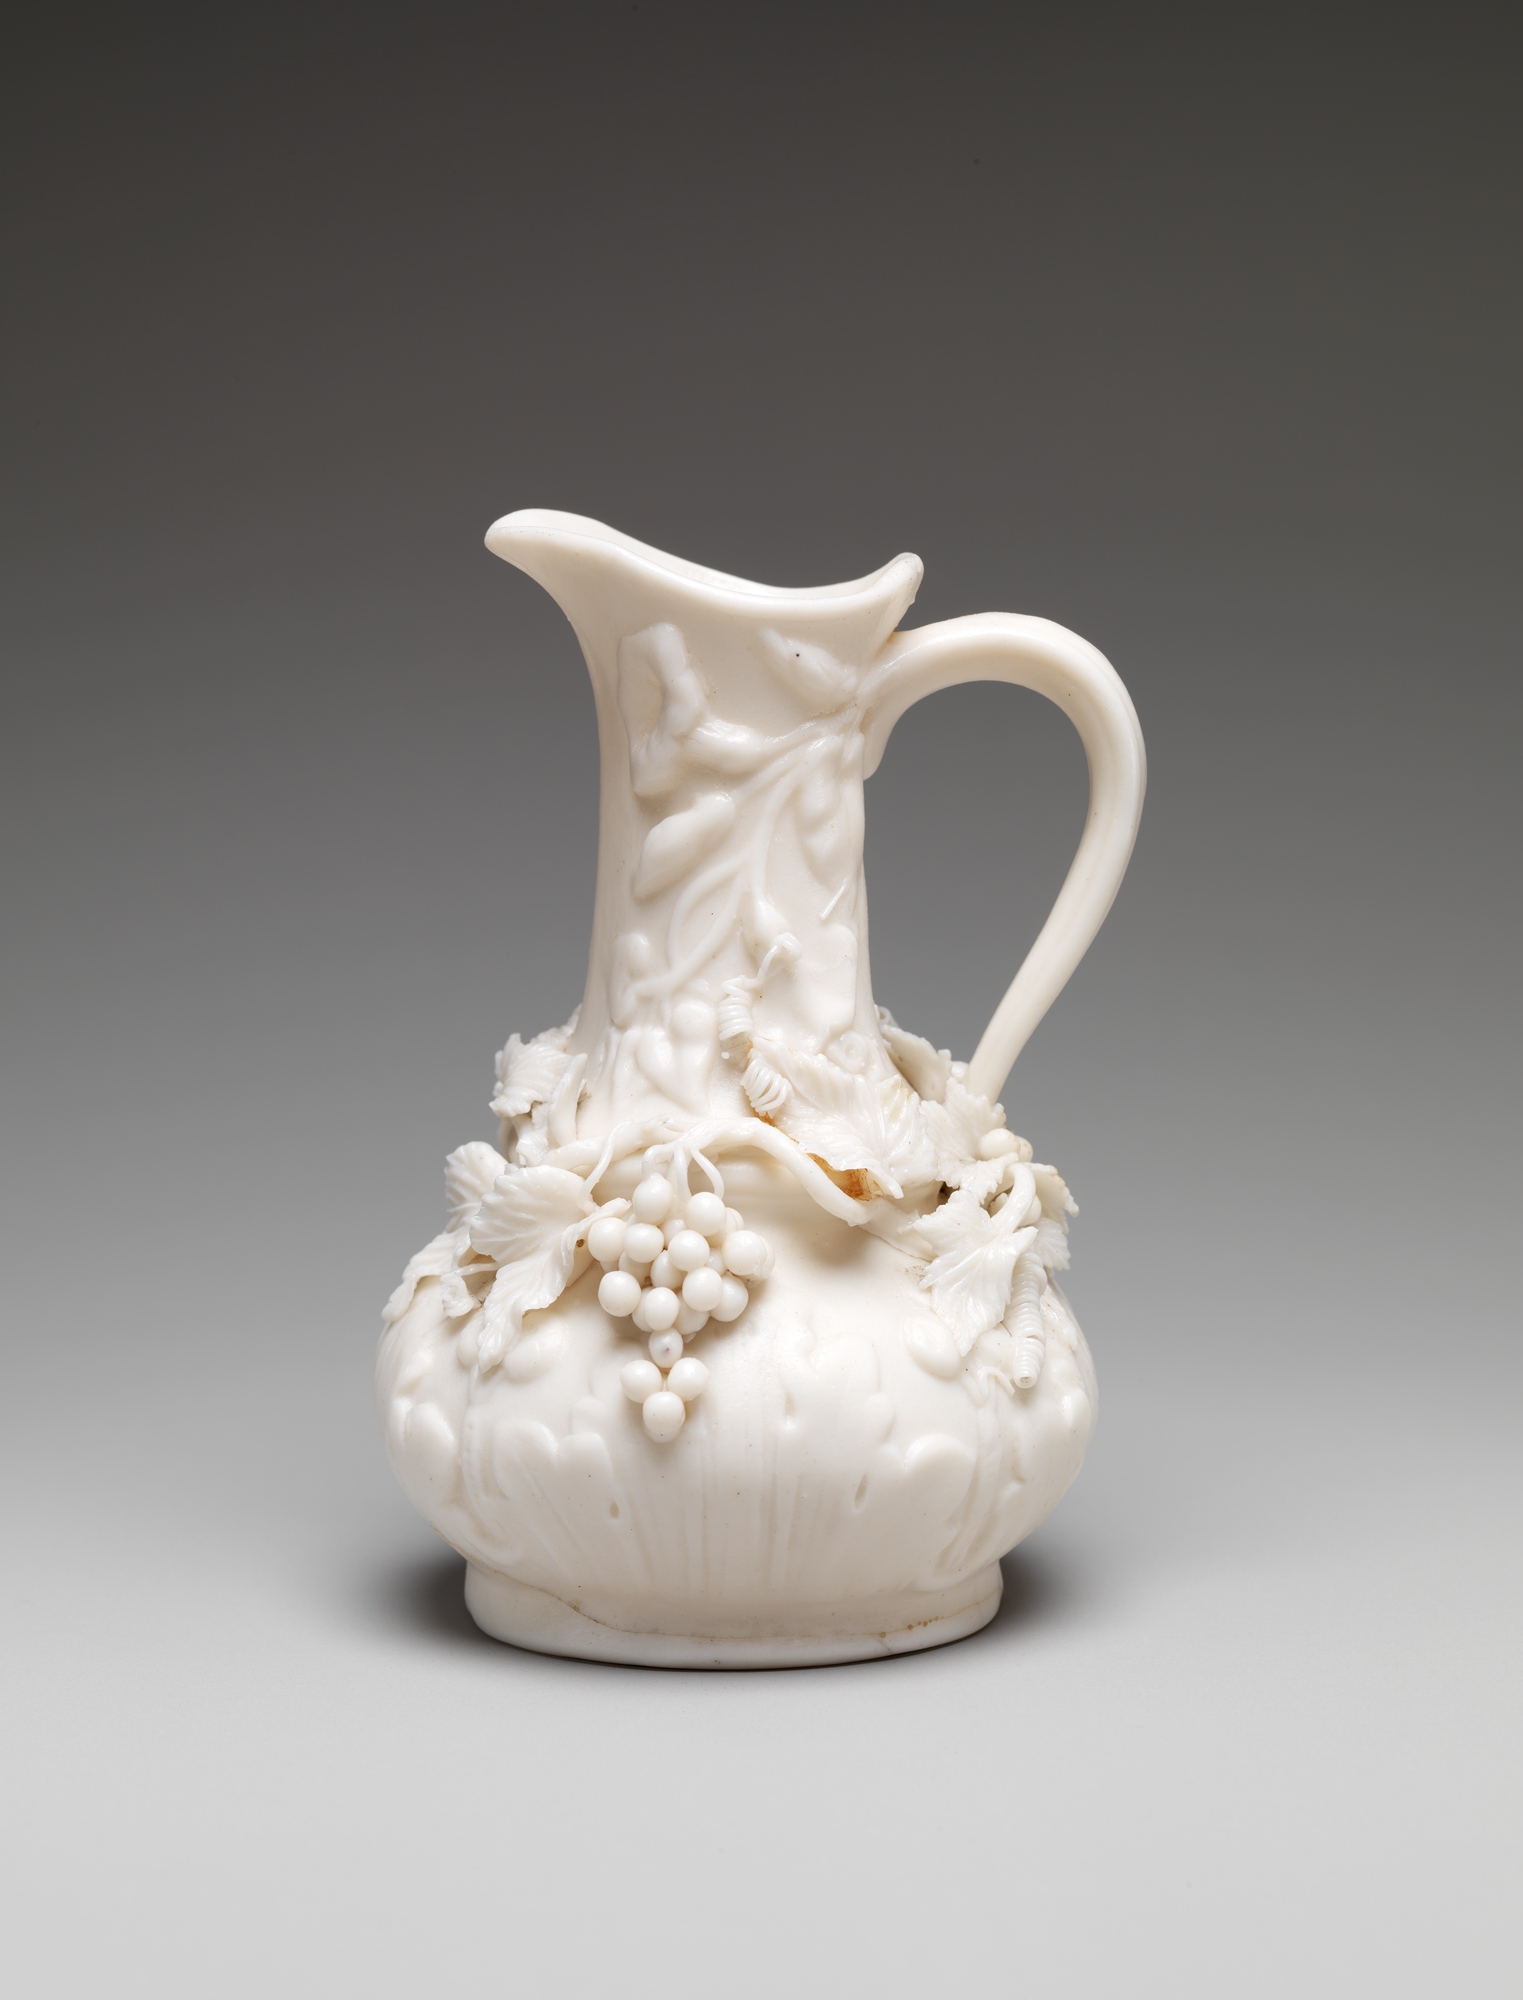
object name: pitcher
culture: american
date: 1830-1870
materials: porcelain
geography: united states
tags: grapes